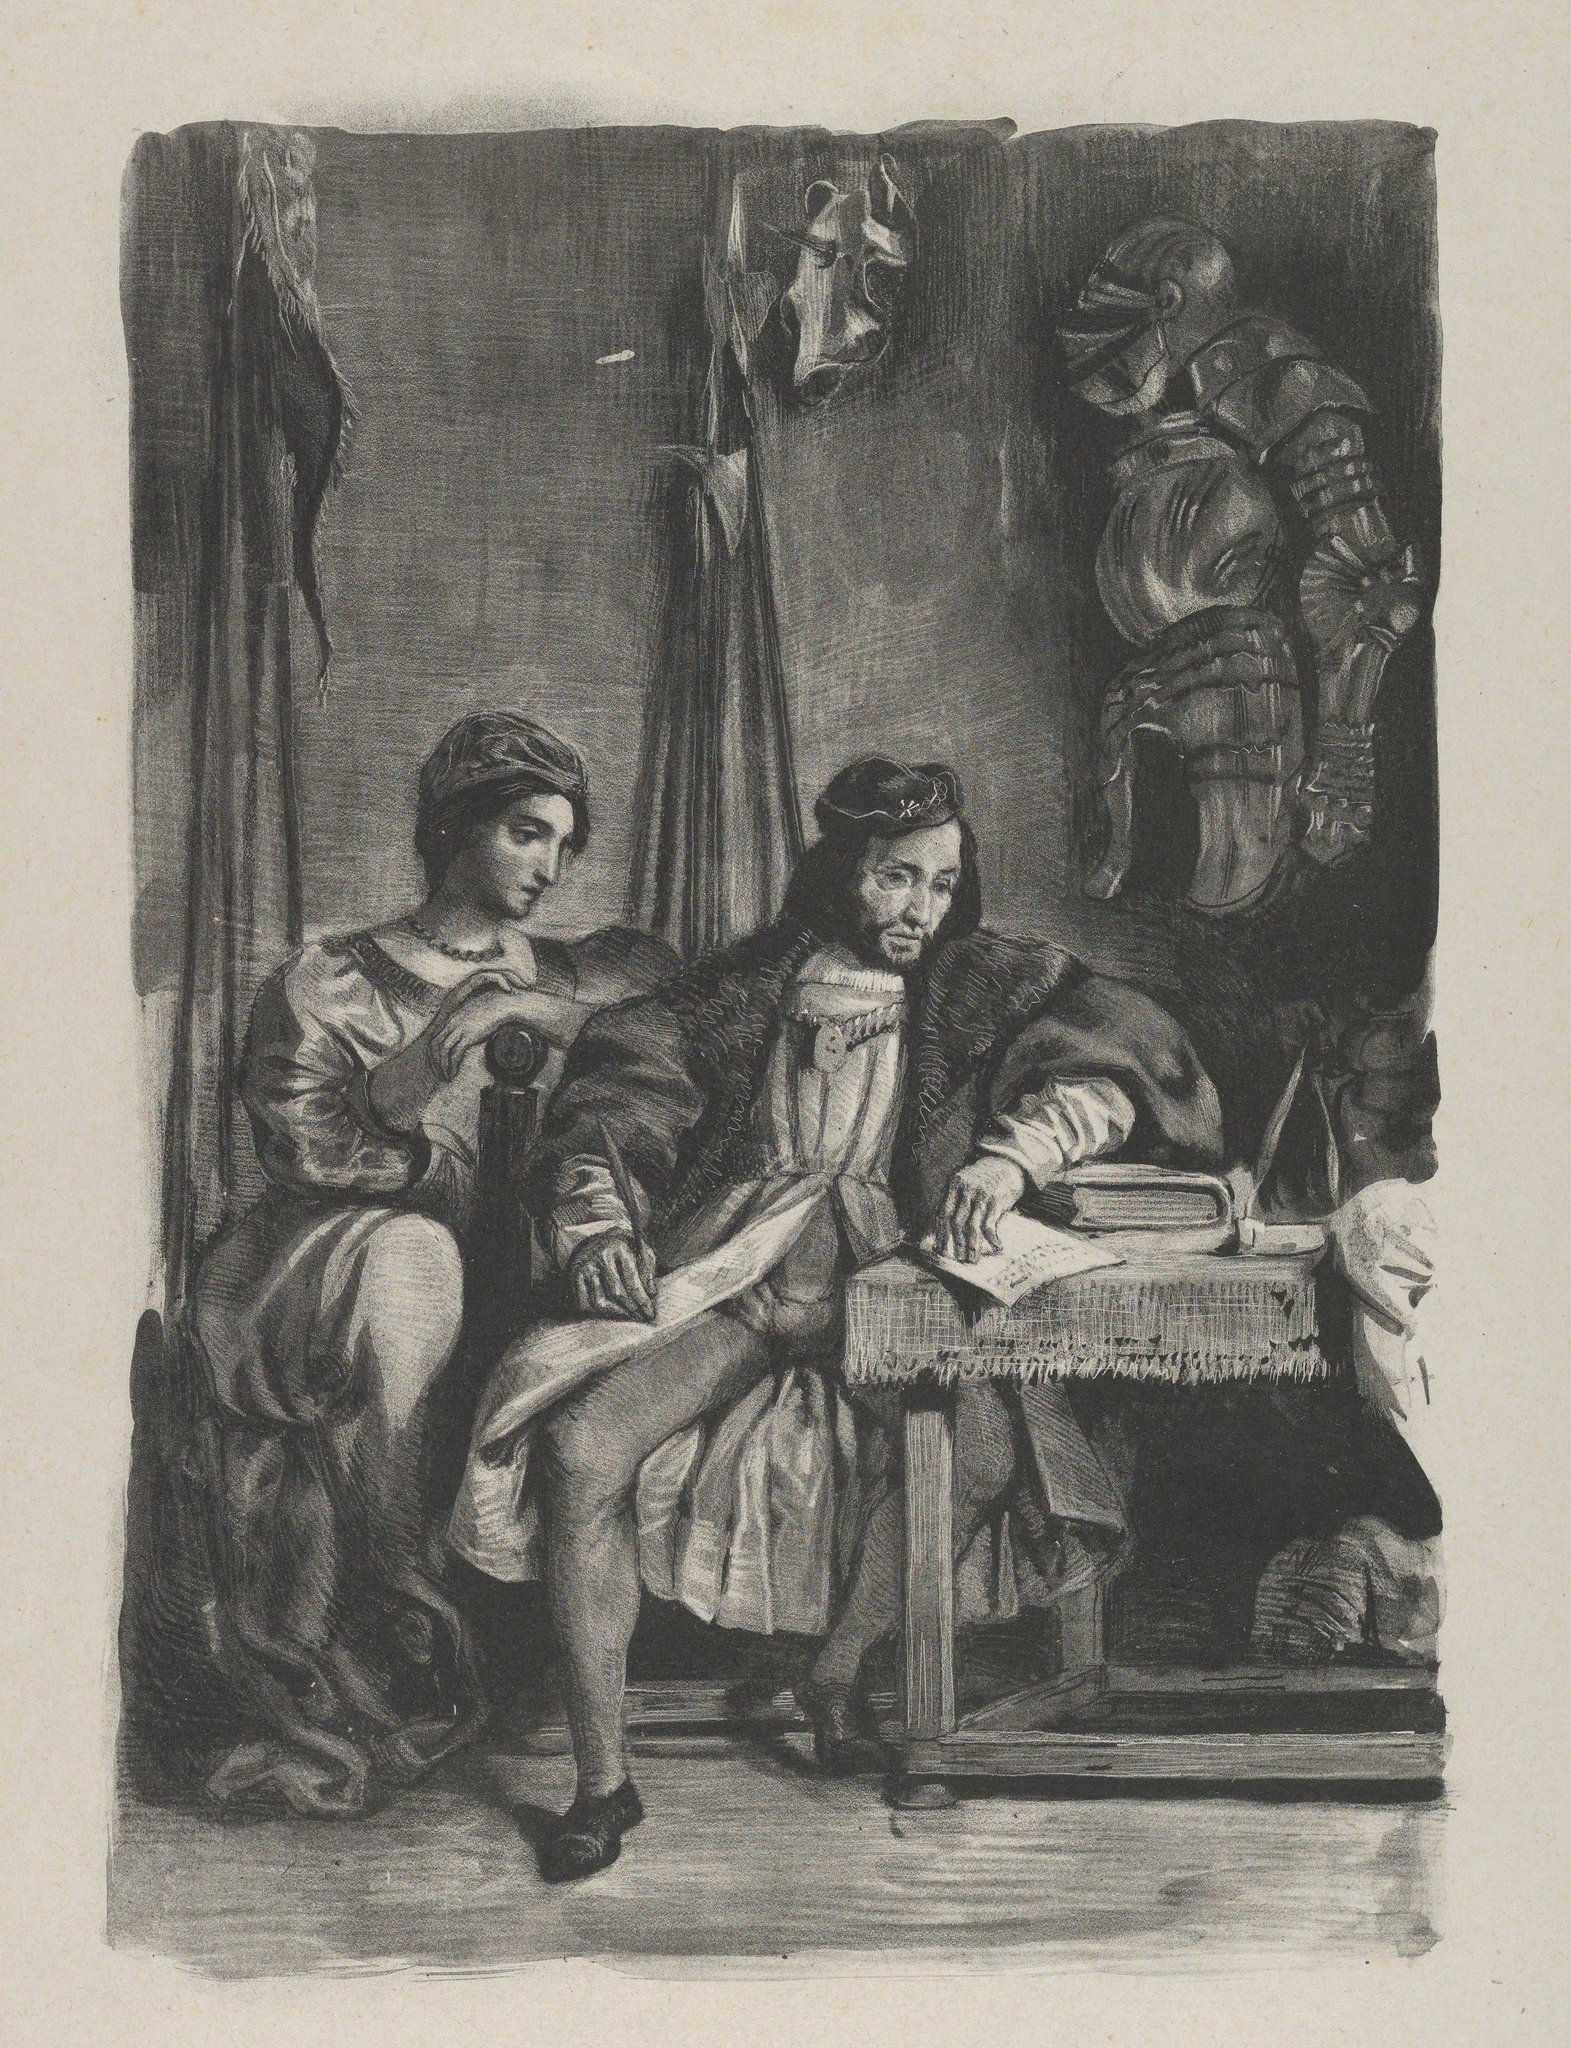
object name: print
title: Goetz von Berlichingen Writing His Memoirs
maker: eugène delacroix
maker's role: artist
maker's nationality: french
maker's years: 1798-1863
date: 1836-1843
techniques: lithograph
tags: armor,men,women,writing